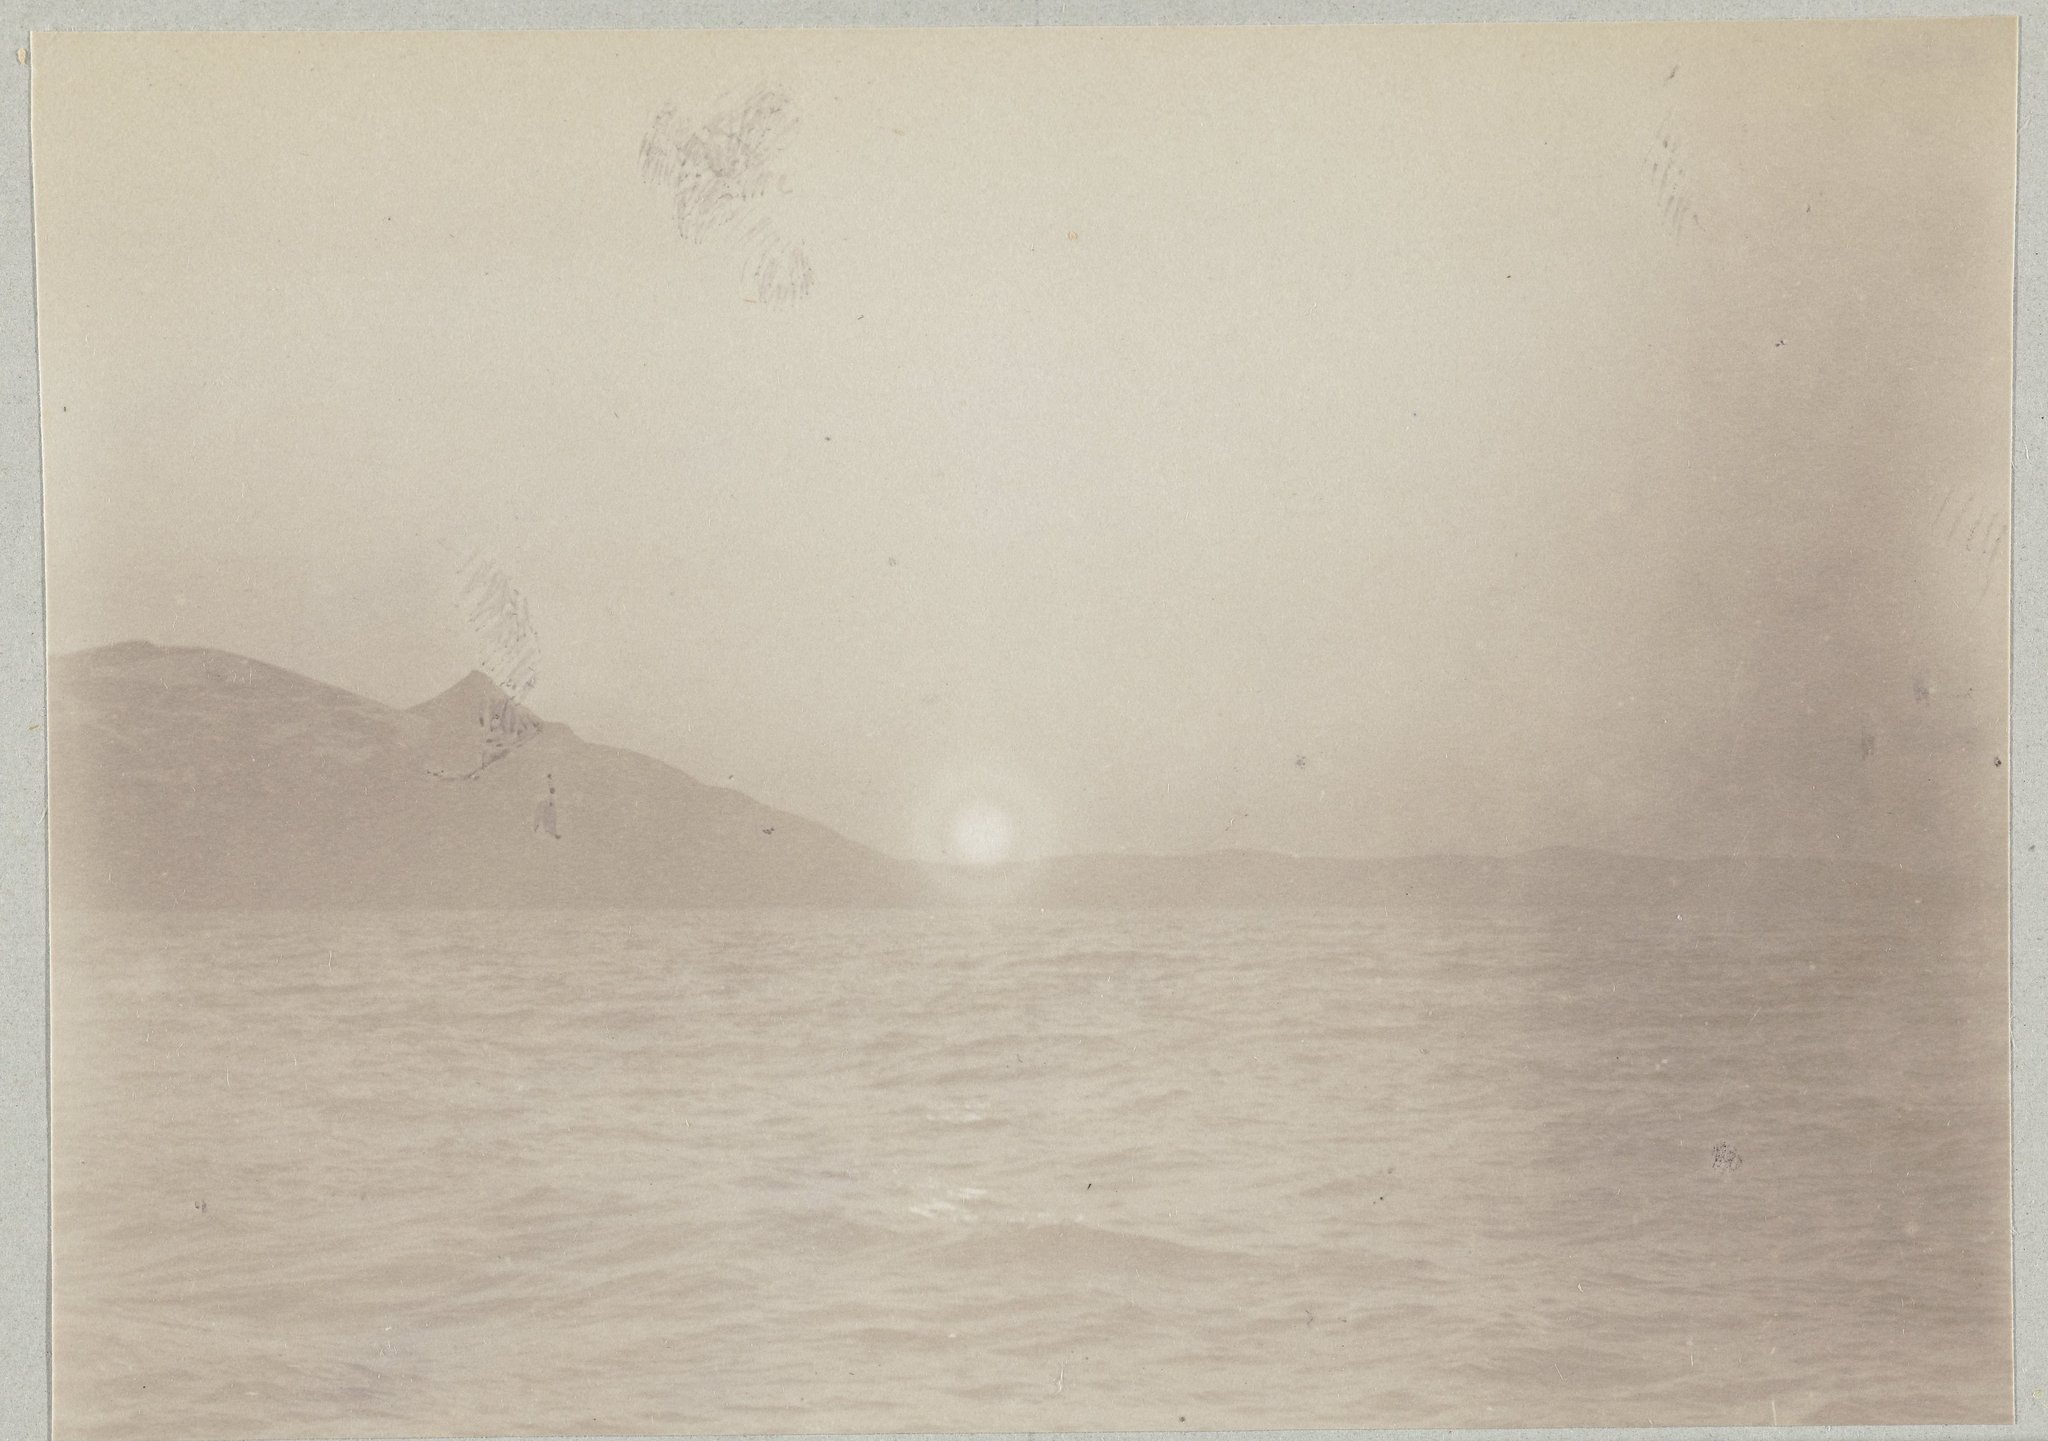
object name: photograph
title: Zonsondergang op zee, gezien vanaf een schip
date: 1807-1889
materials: cardboard, paper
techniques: albumen print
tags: wilhelm ii (keizer van duitsland), norway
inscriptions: number: ‘28’